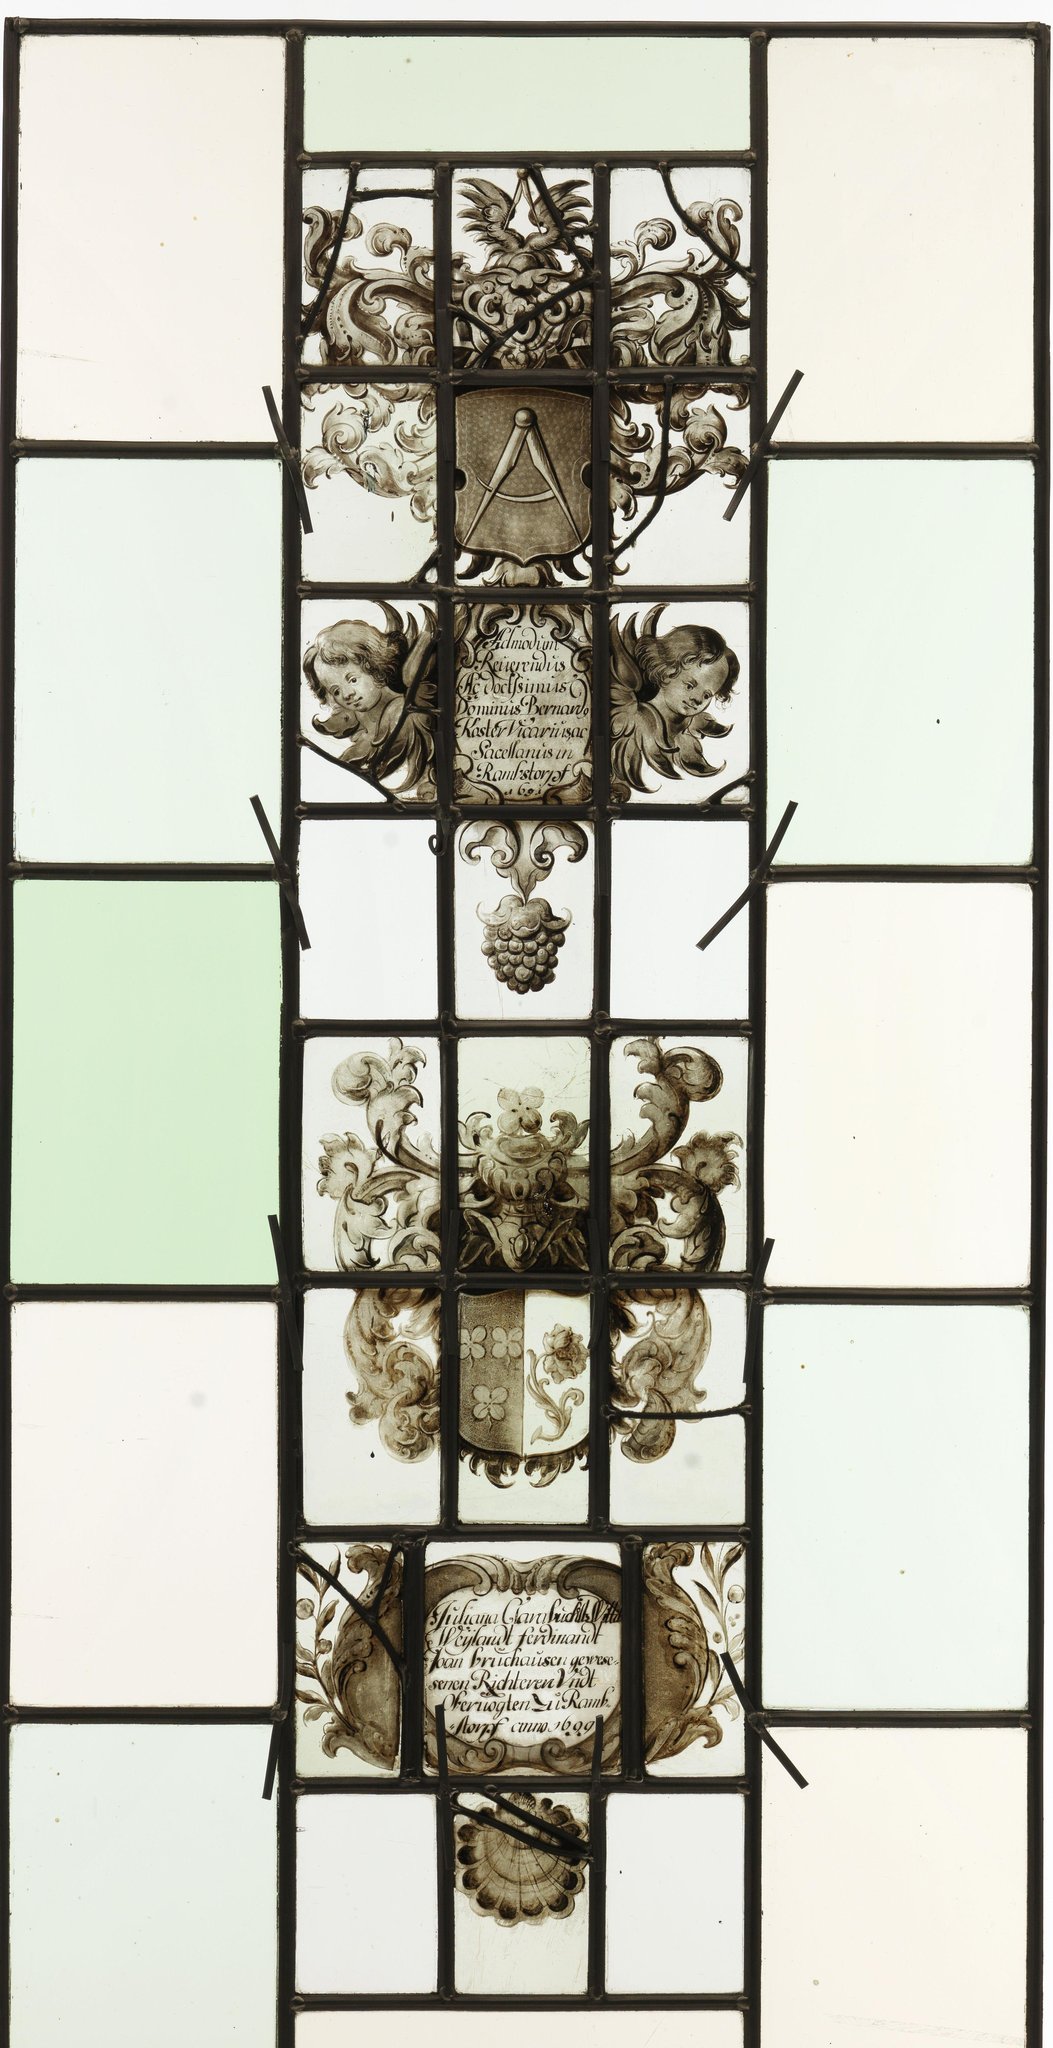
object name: light window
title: Ruit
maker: Anonymous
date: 1691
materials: glass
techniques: enamel painting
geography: westphalia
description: Ruit met gebrandschilderde voorstelling, zit vast aan BK-2000-10-D.